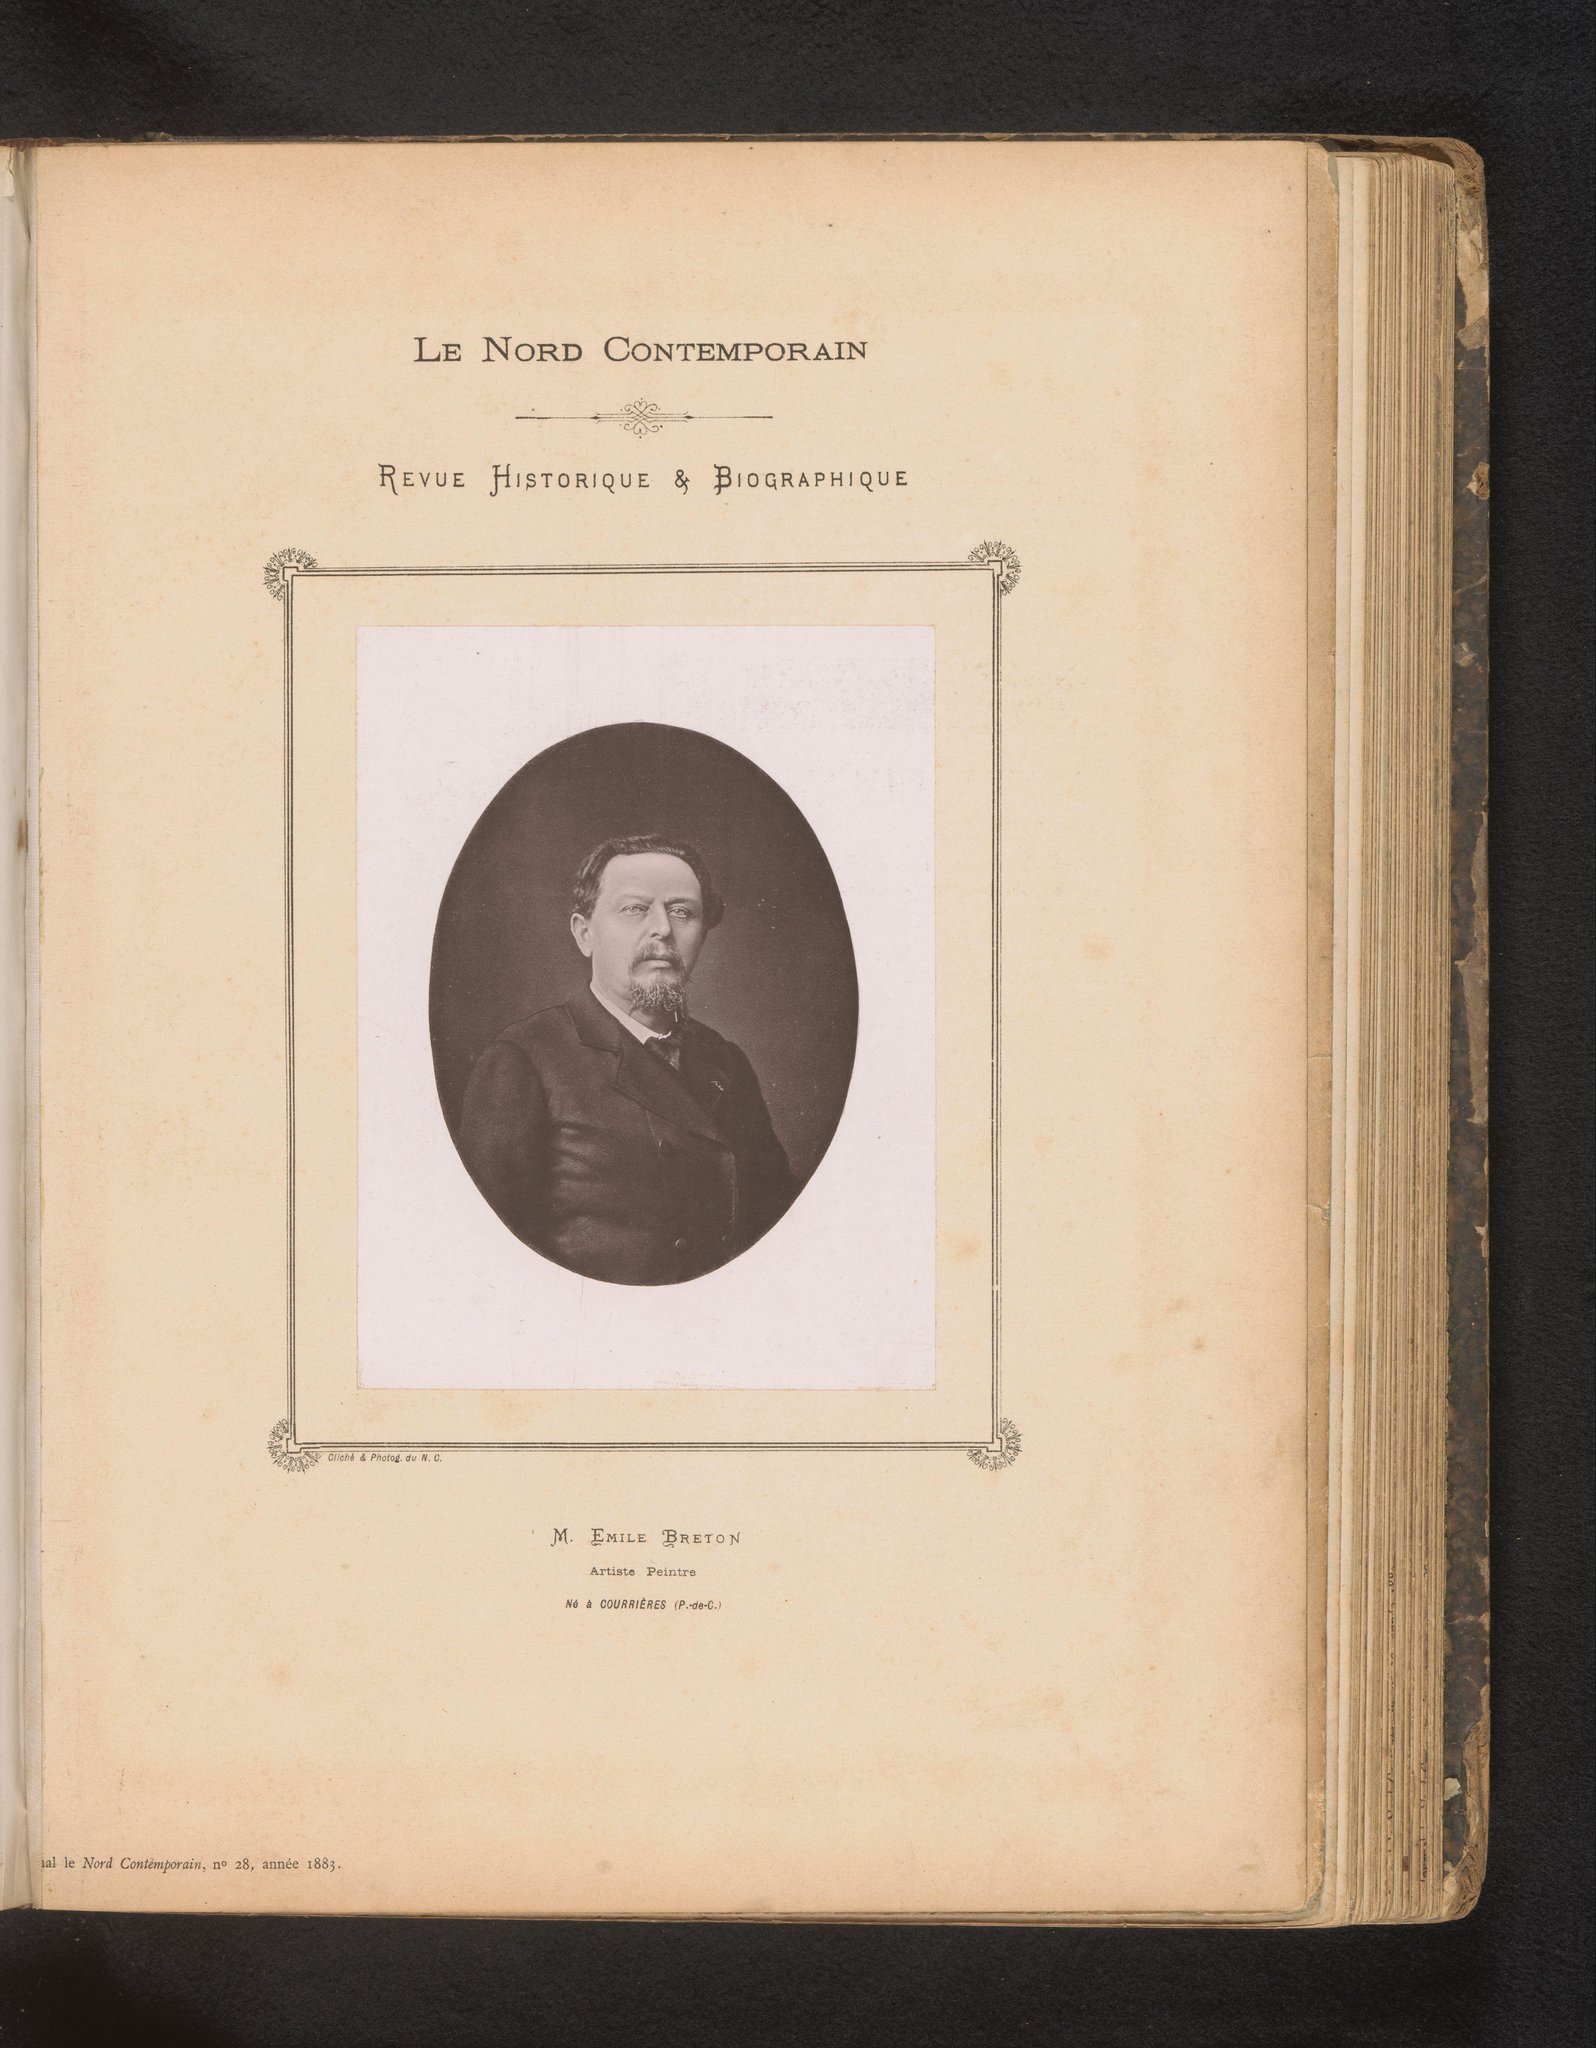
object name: page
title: Portret van Émile Breton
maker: n.c.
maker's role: fotograaf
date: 1878-1883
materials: paper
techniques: photograph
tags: emile adélard breton, historical persons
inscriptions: inscription: ‘Né à Courrières (P.-de-C.)’, inscription: ‘[Journ]al le Nord Contemporain, No 28, année 1883.’, inscription: ‘Le Nord Contemporain/ Revue Historique & Biographique’